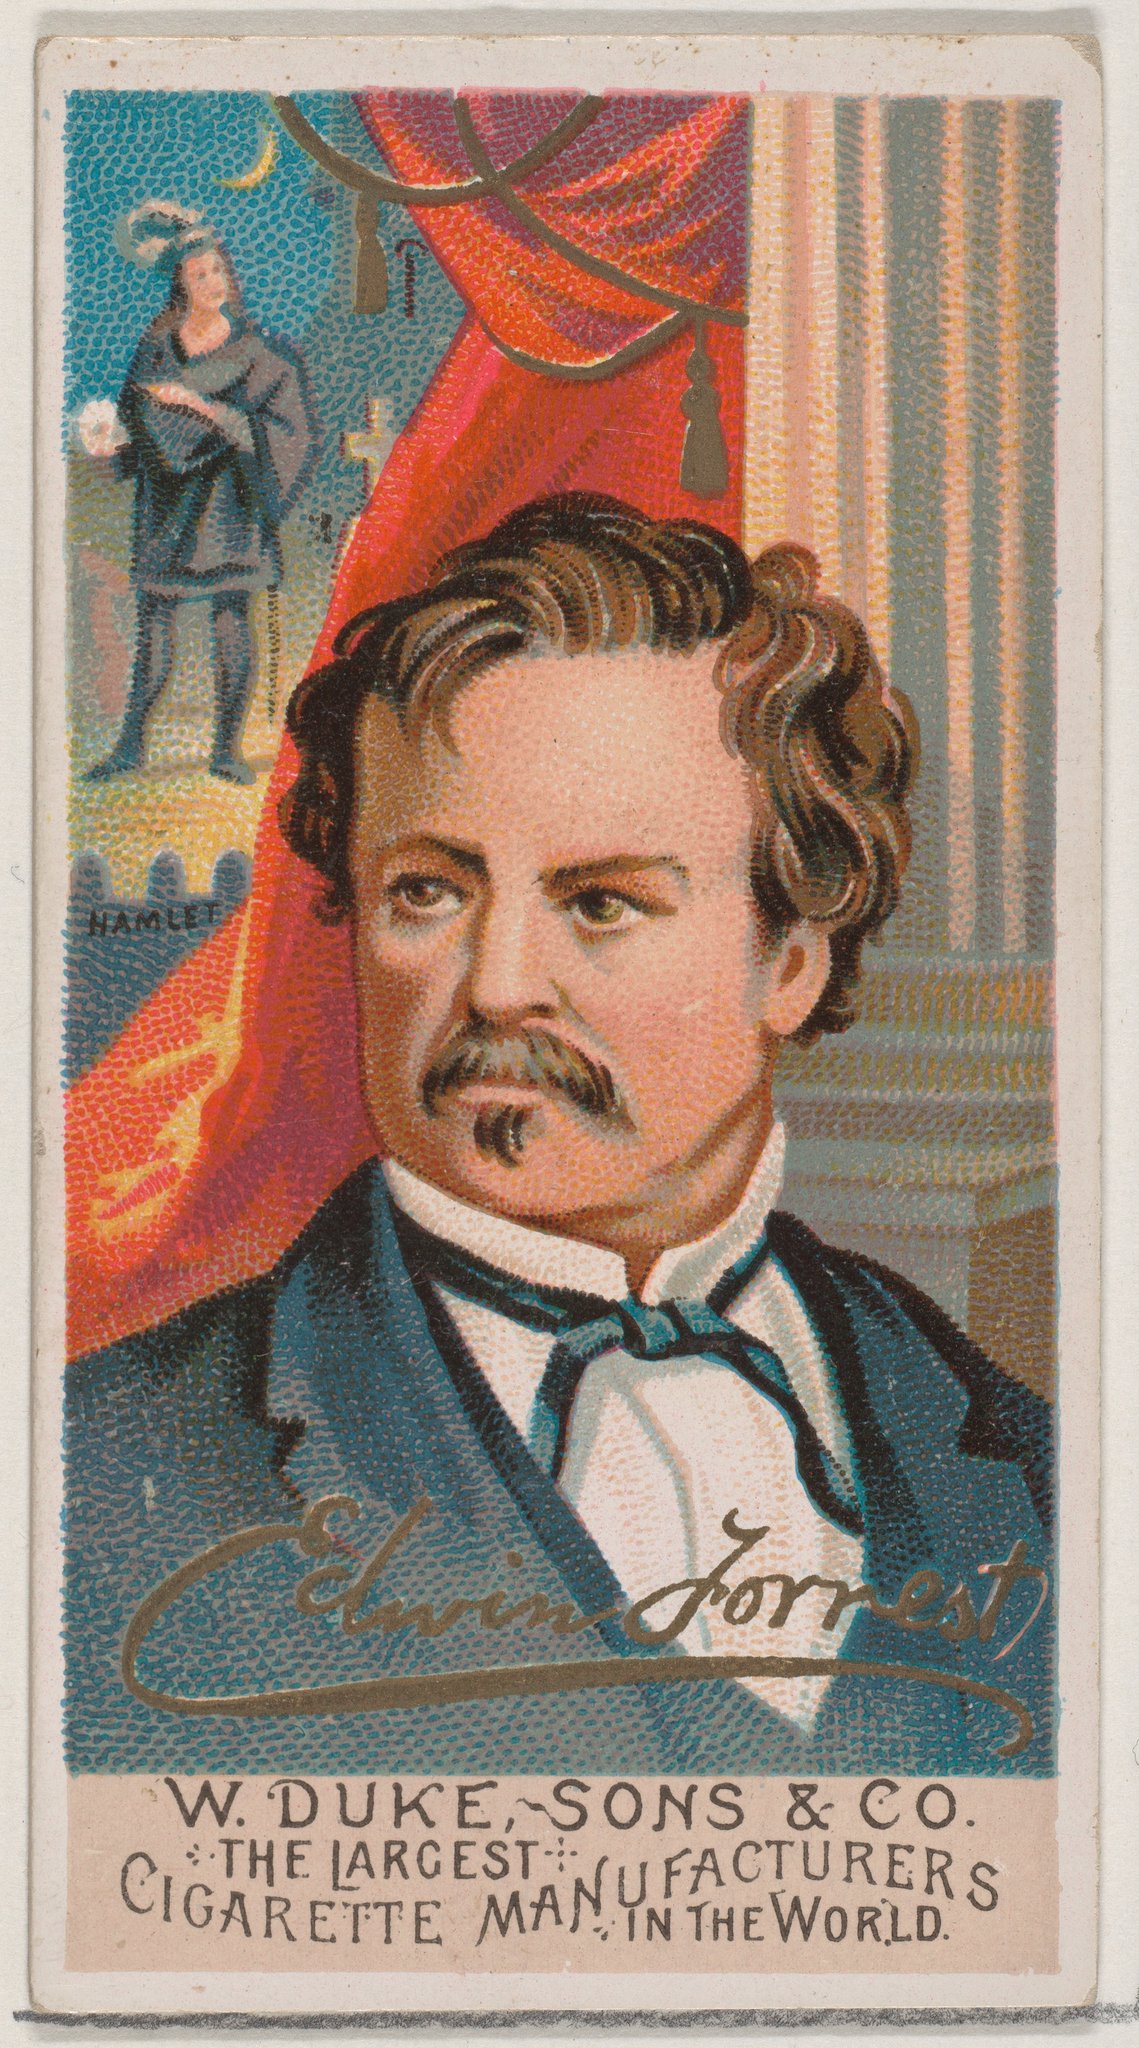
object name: print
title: Edwin Forrest, from the series Great Americans (N76) for Duke brand cigarettes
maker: w. duke, sons & co.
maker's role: publisher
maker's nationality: american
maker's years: 1870-1920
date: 1888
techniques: color lithograph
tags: men